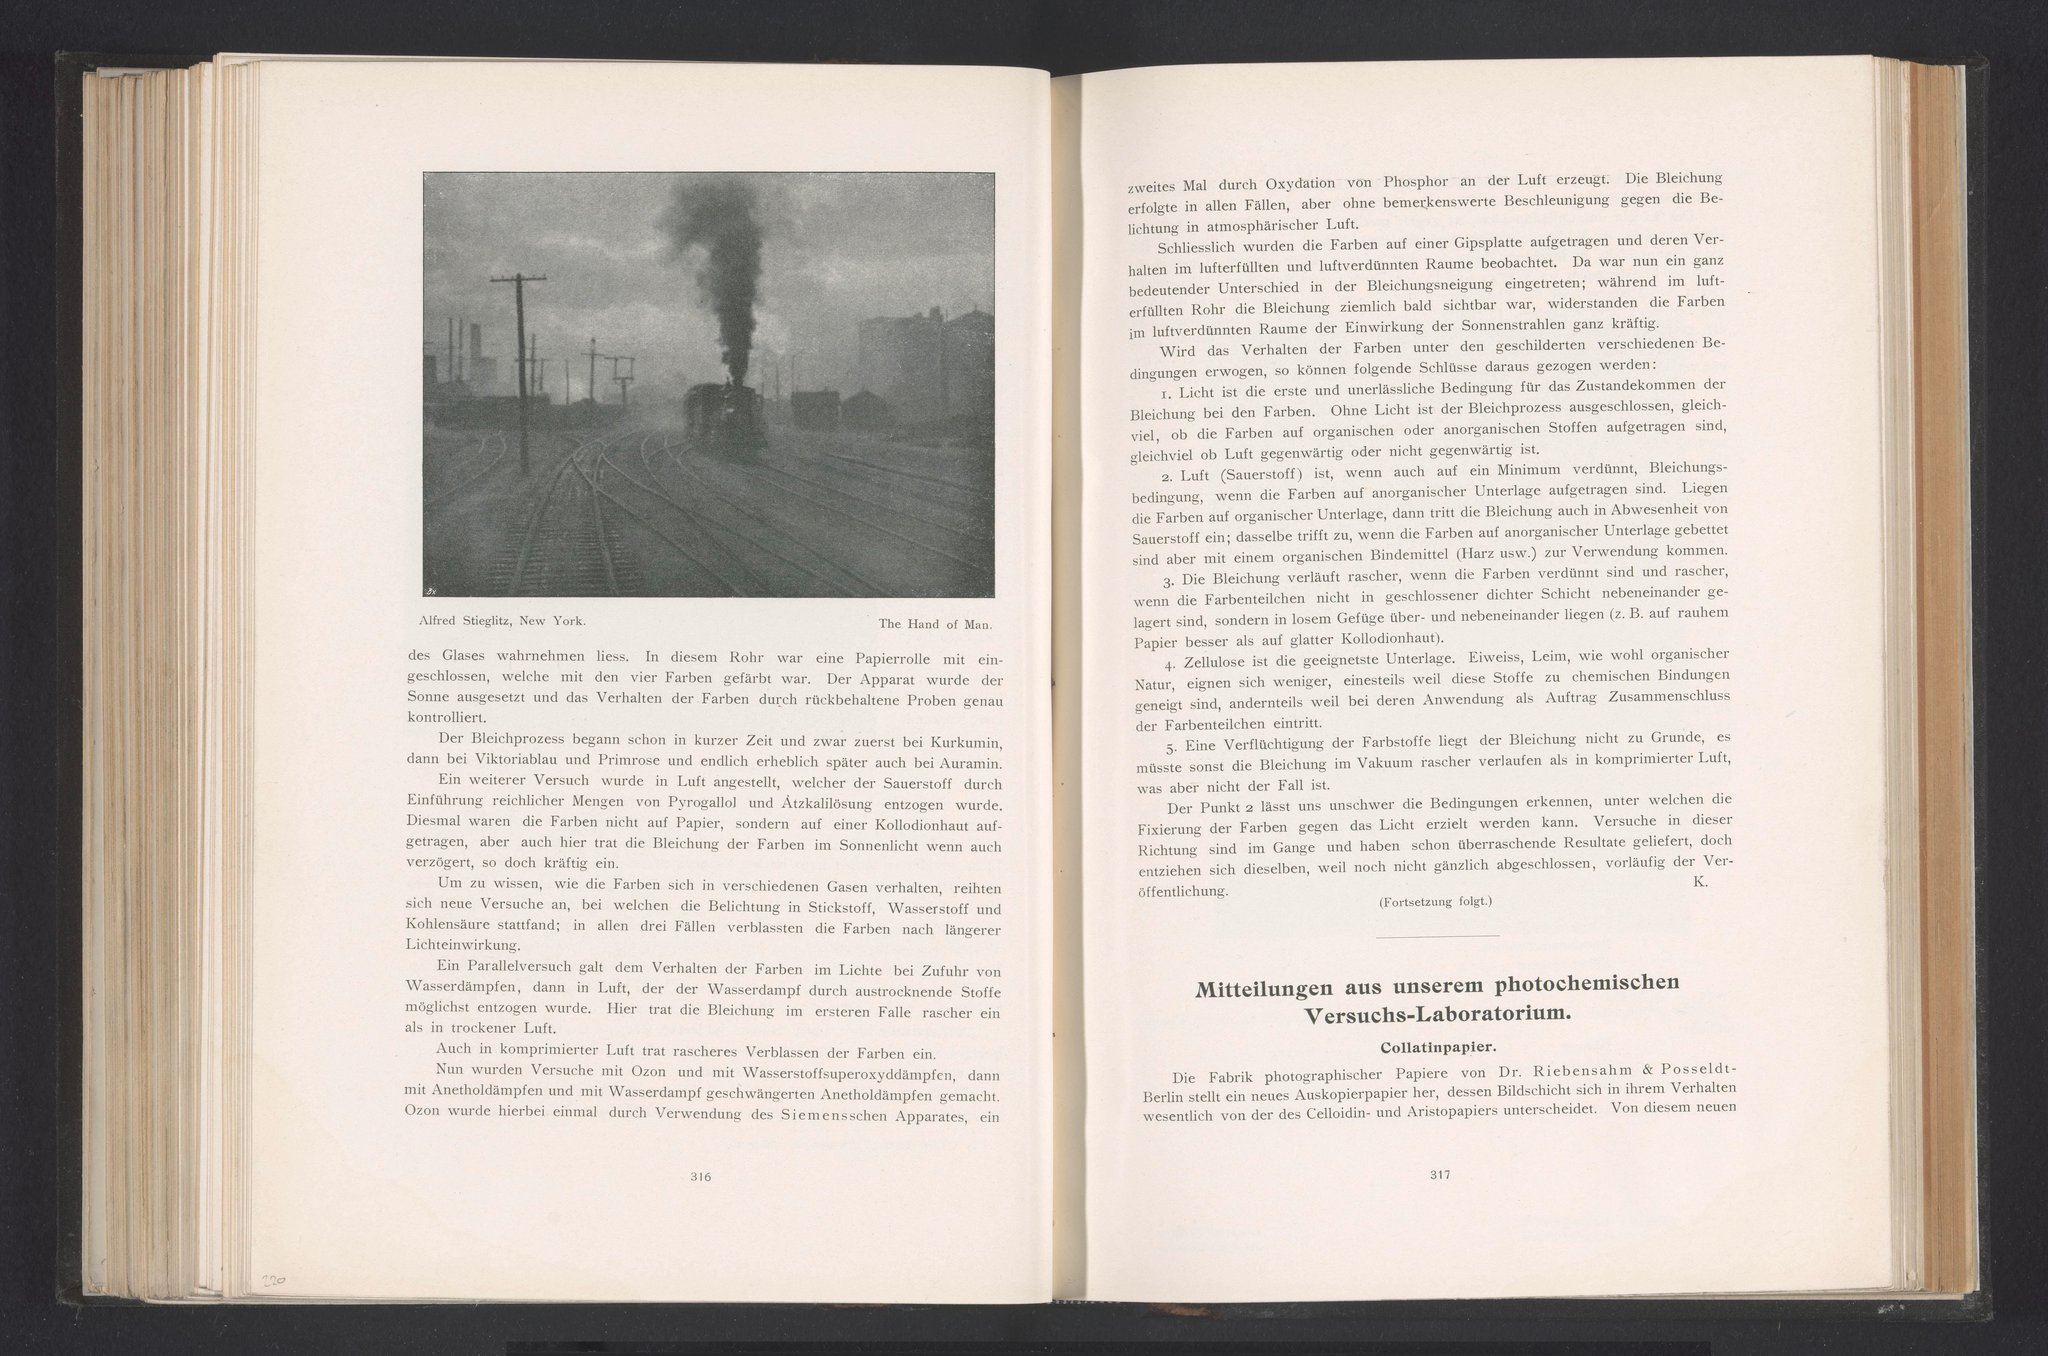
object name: photomechanical print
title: The Hand of Man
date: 1898-1903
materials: paper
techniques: autotype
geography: new york city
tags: railway, train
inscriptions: monogram: ‘BX’